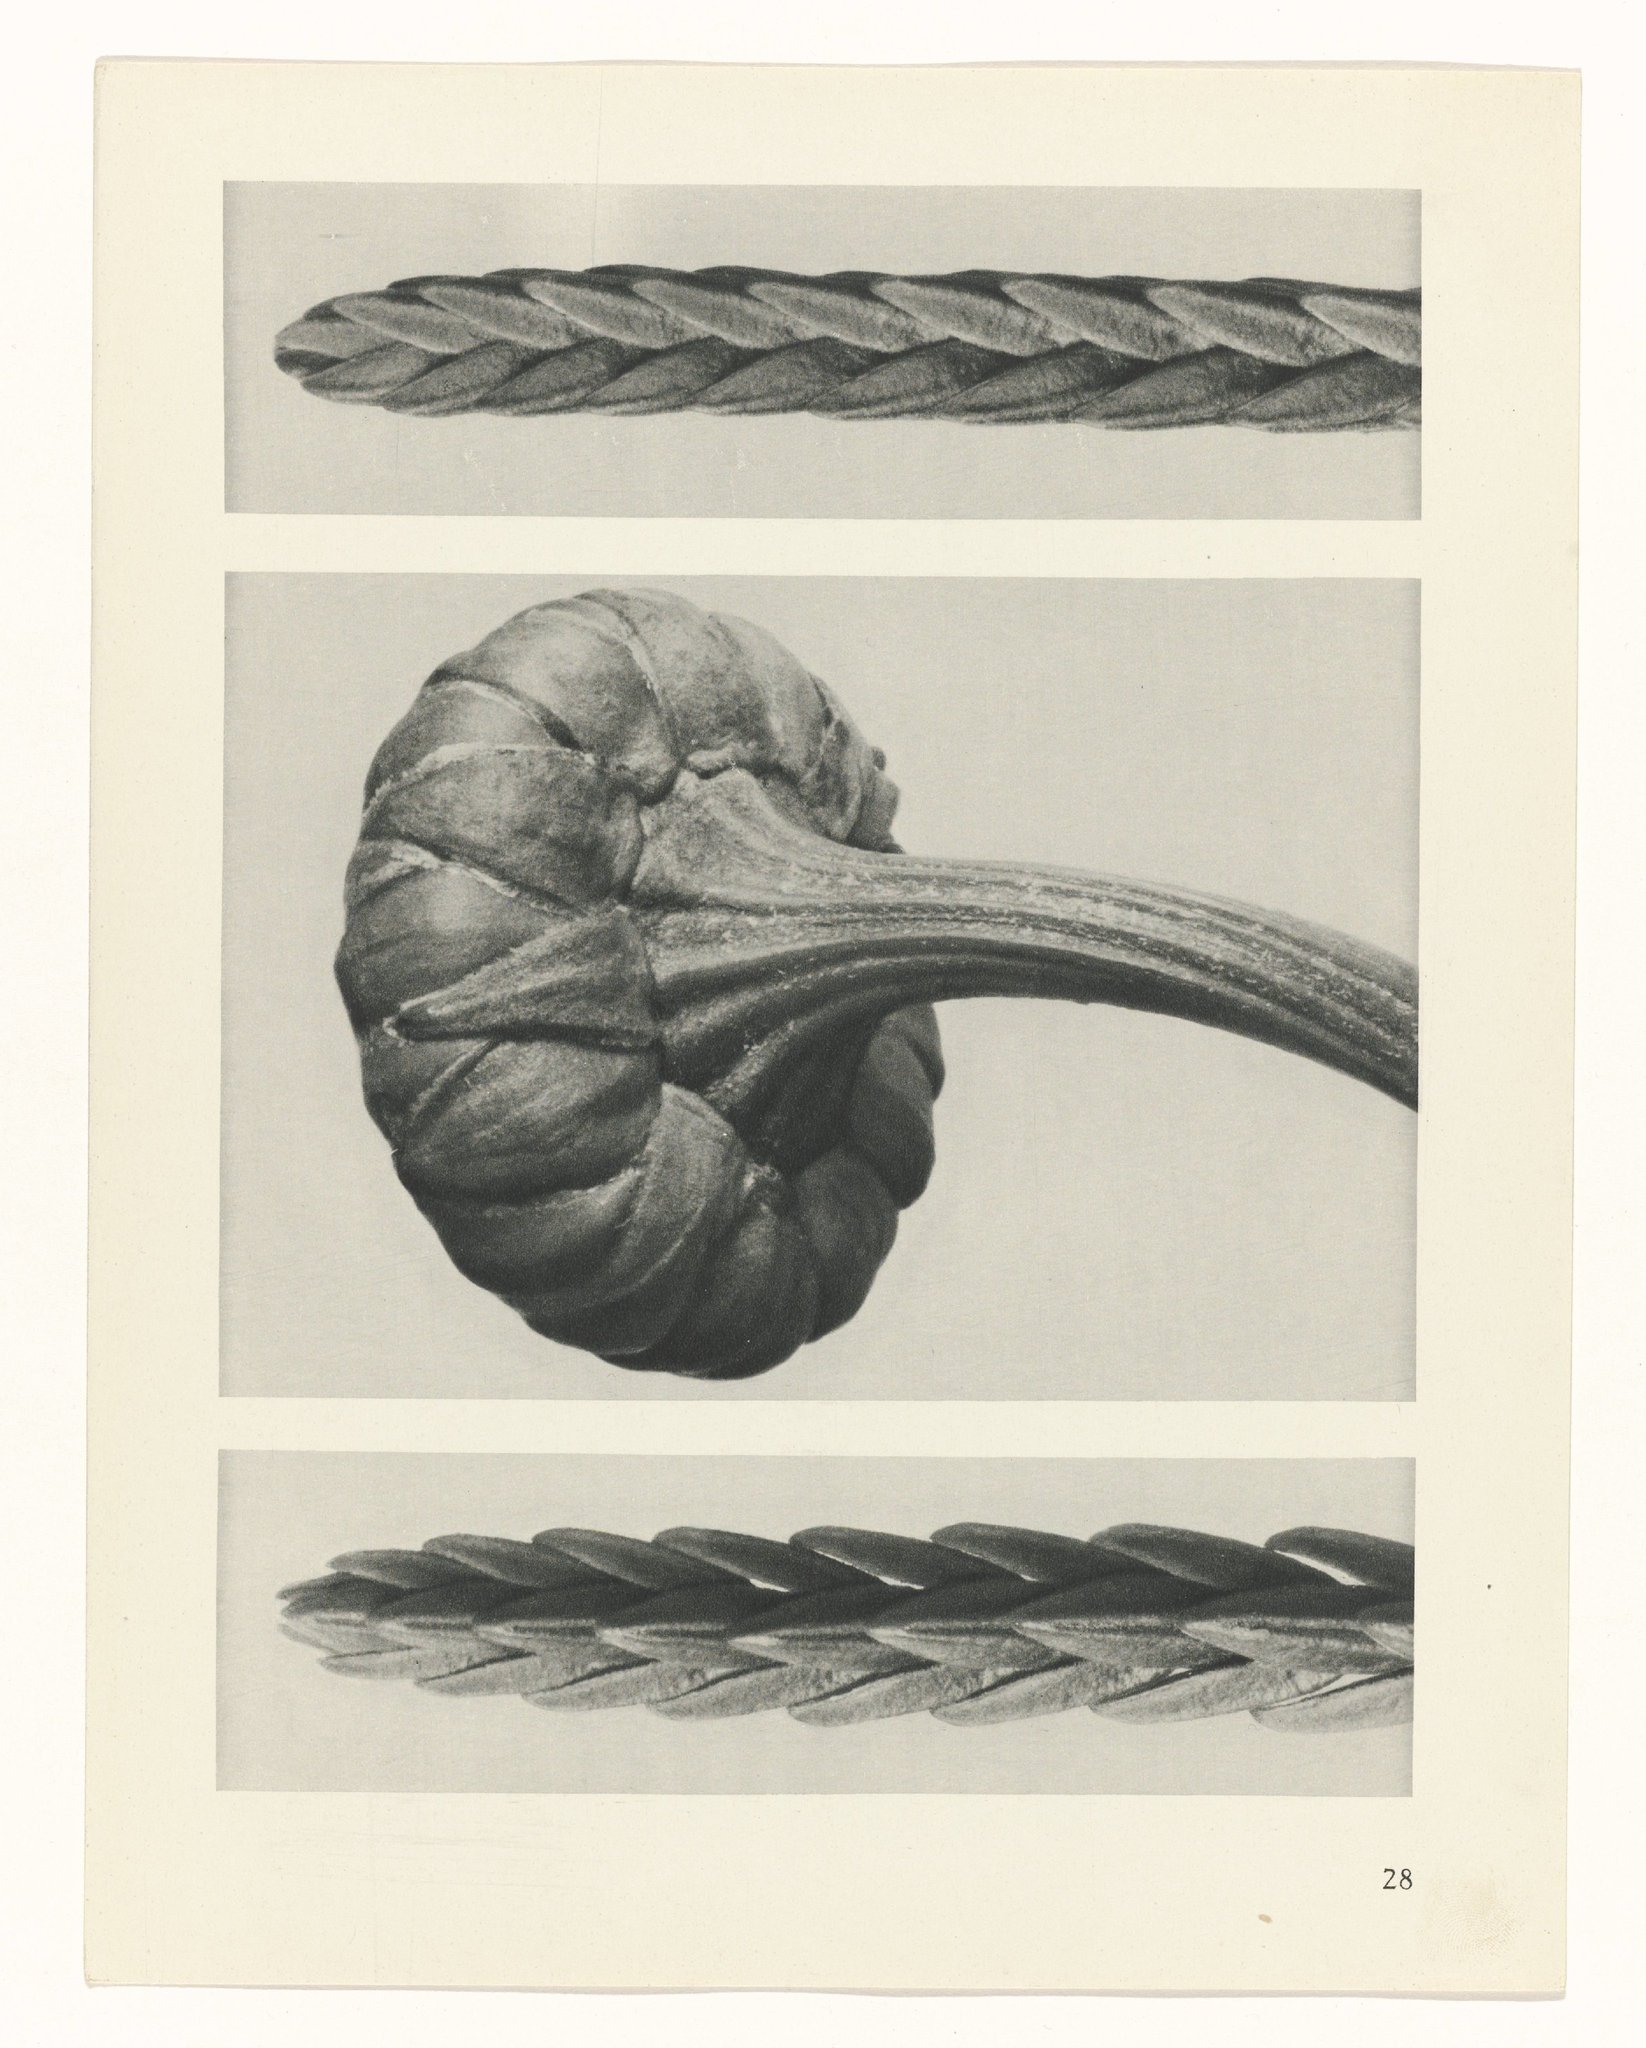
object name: photograph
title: Urformen der Kunst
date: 1928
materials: ink, paper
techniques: rotogravure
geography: berlin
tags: plants (in general)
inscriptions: number: ‘28’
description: facher Vergrößerung. Afkomstig uit losbladige uitgave.